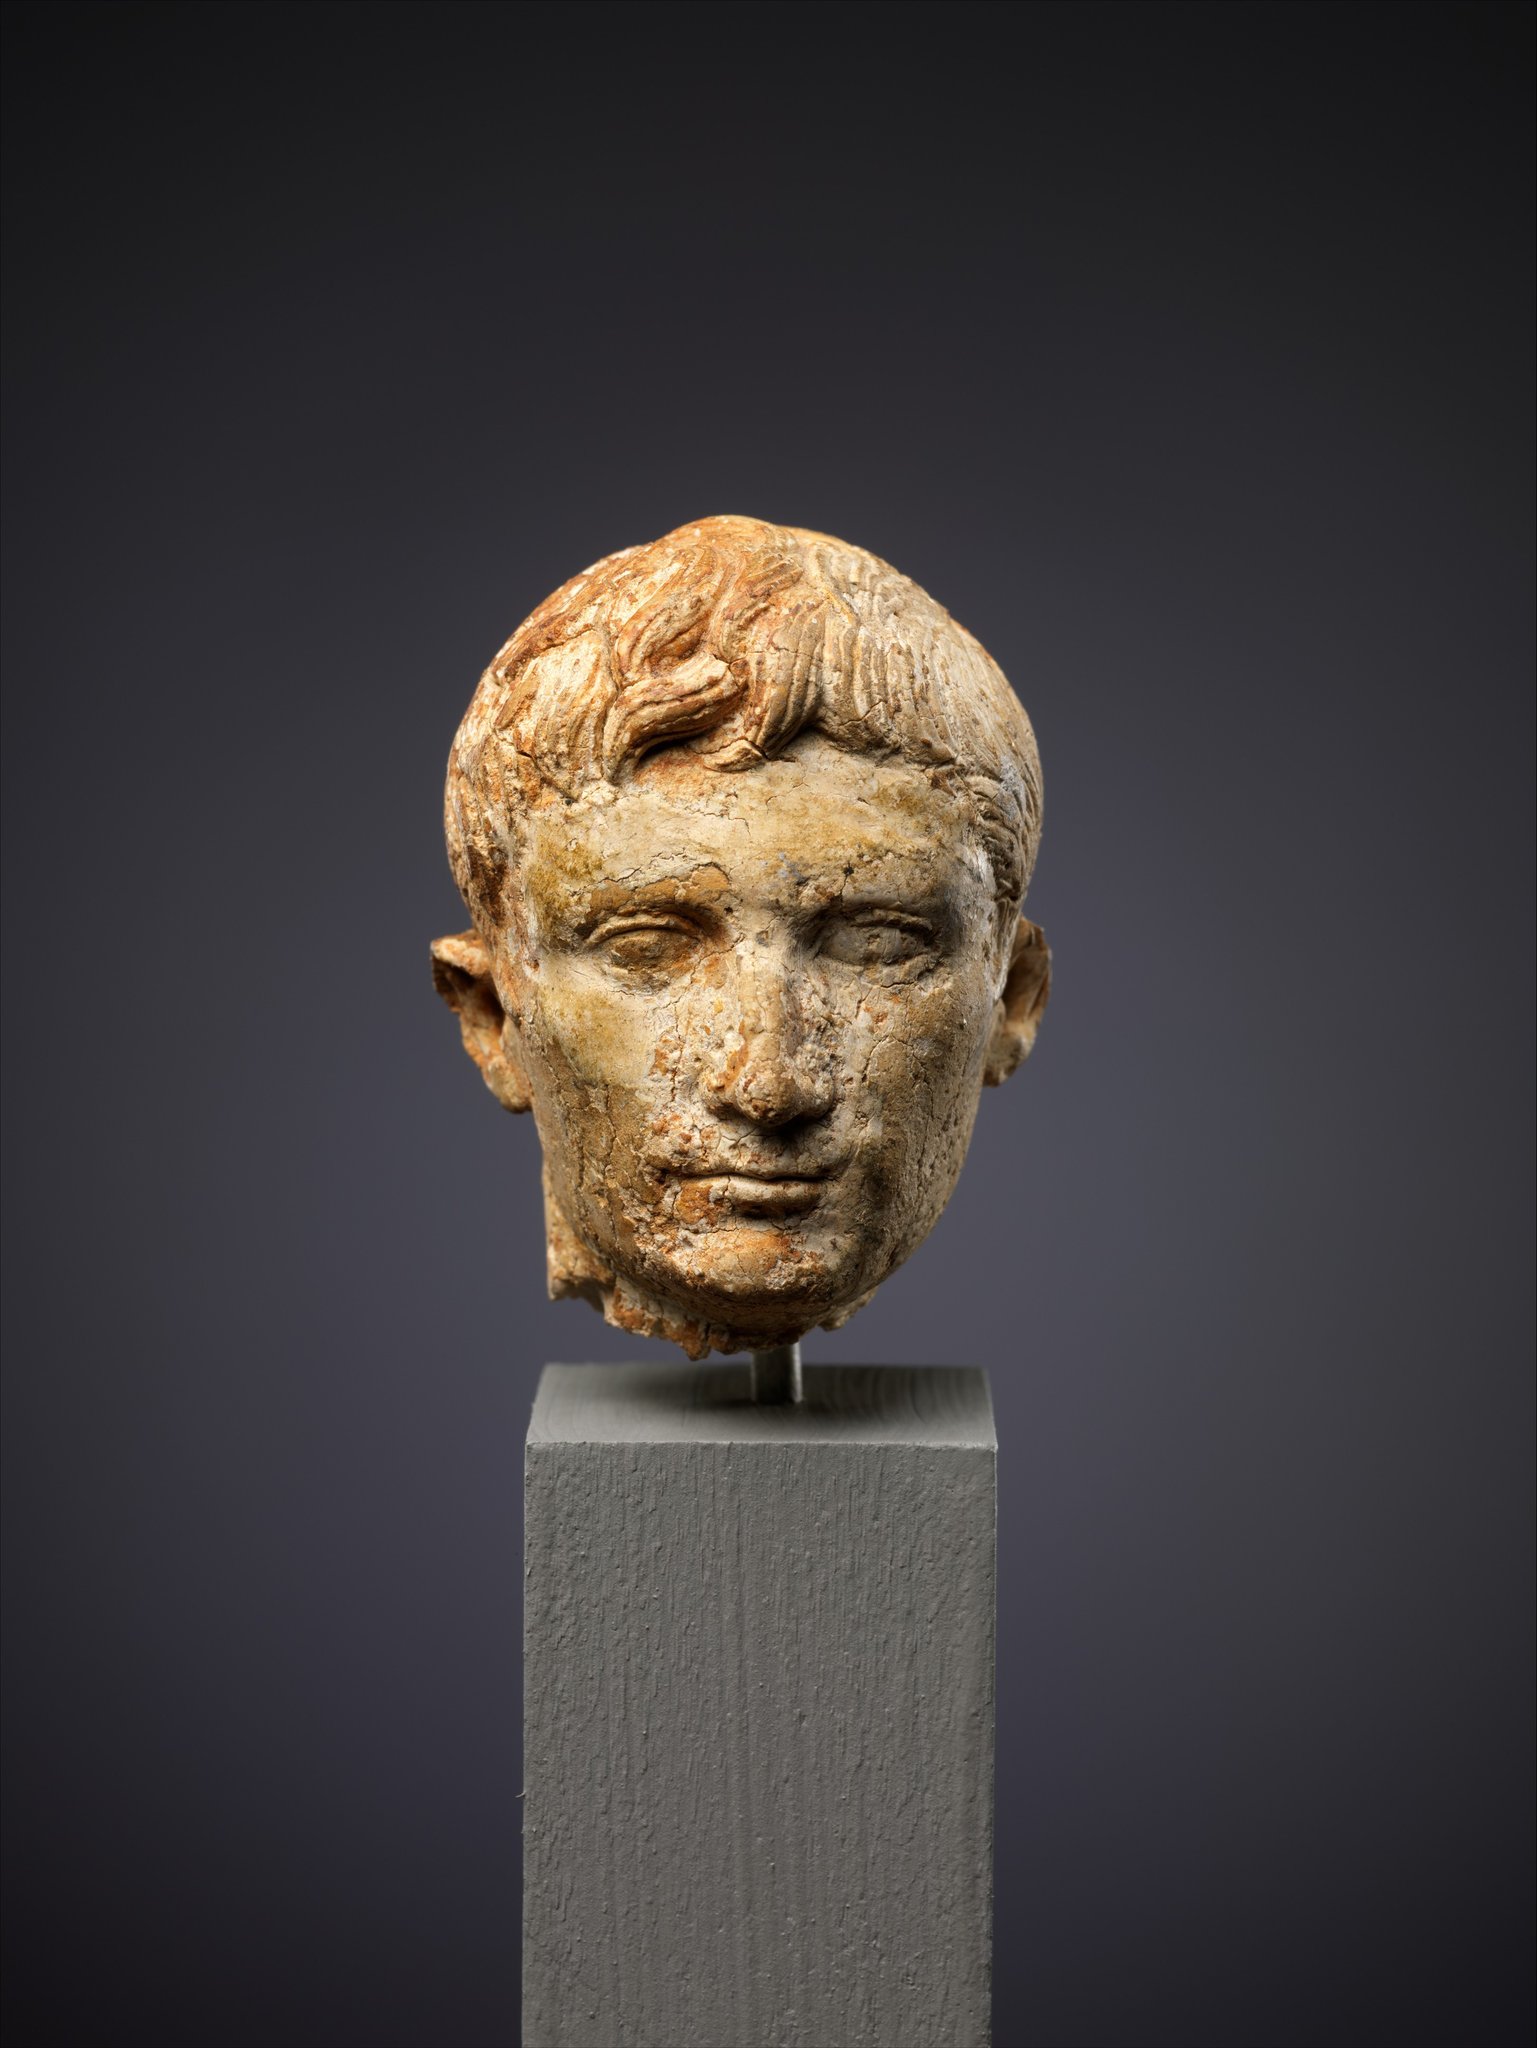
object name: portrait head of the emperor augustus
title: Ivory portrait head of the emperor Augustus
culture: roman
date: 27 BCE-14 CE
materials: ivory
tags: emperor augustus,heads,portraits